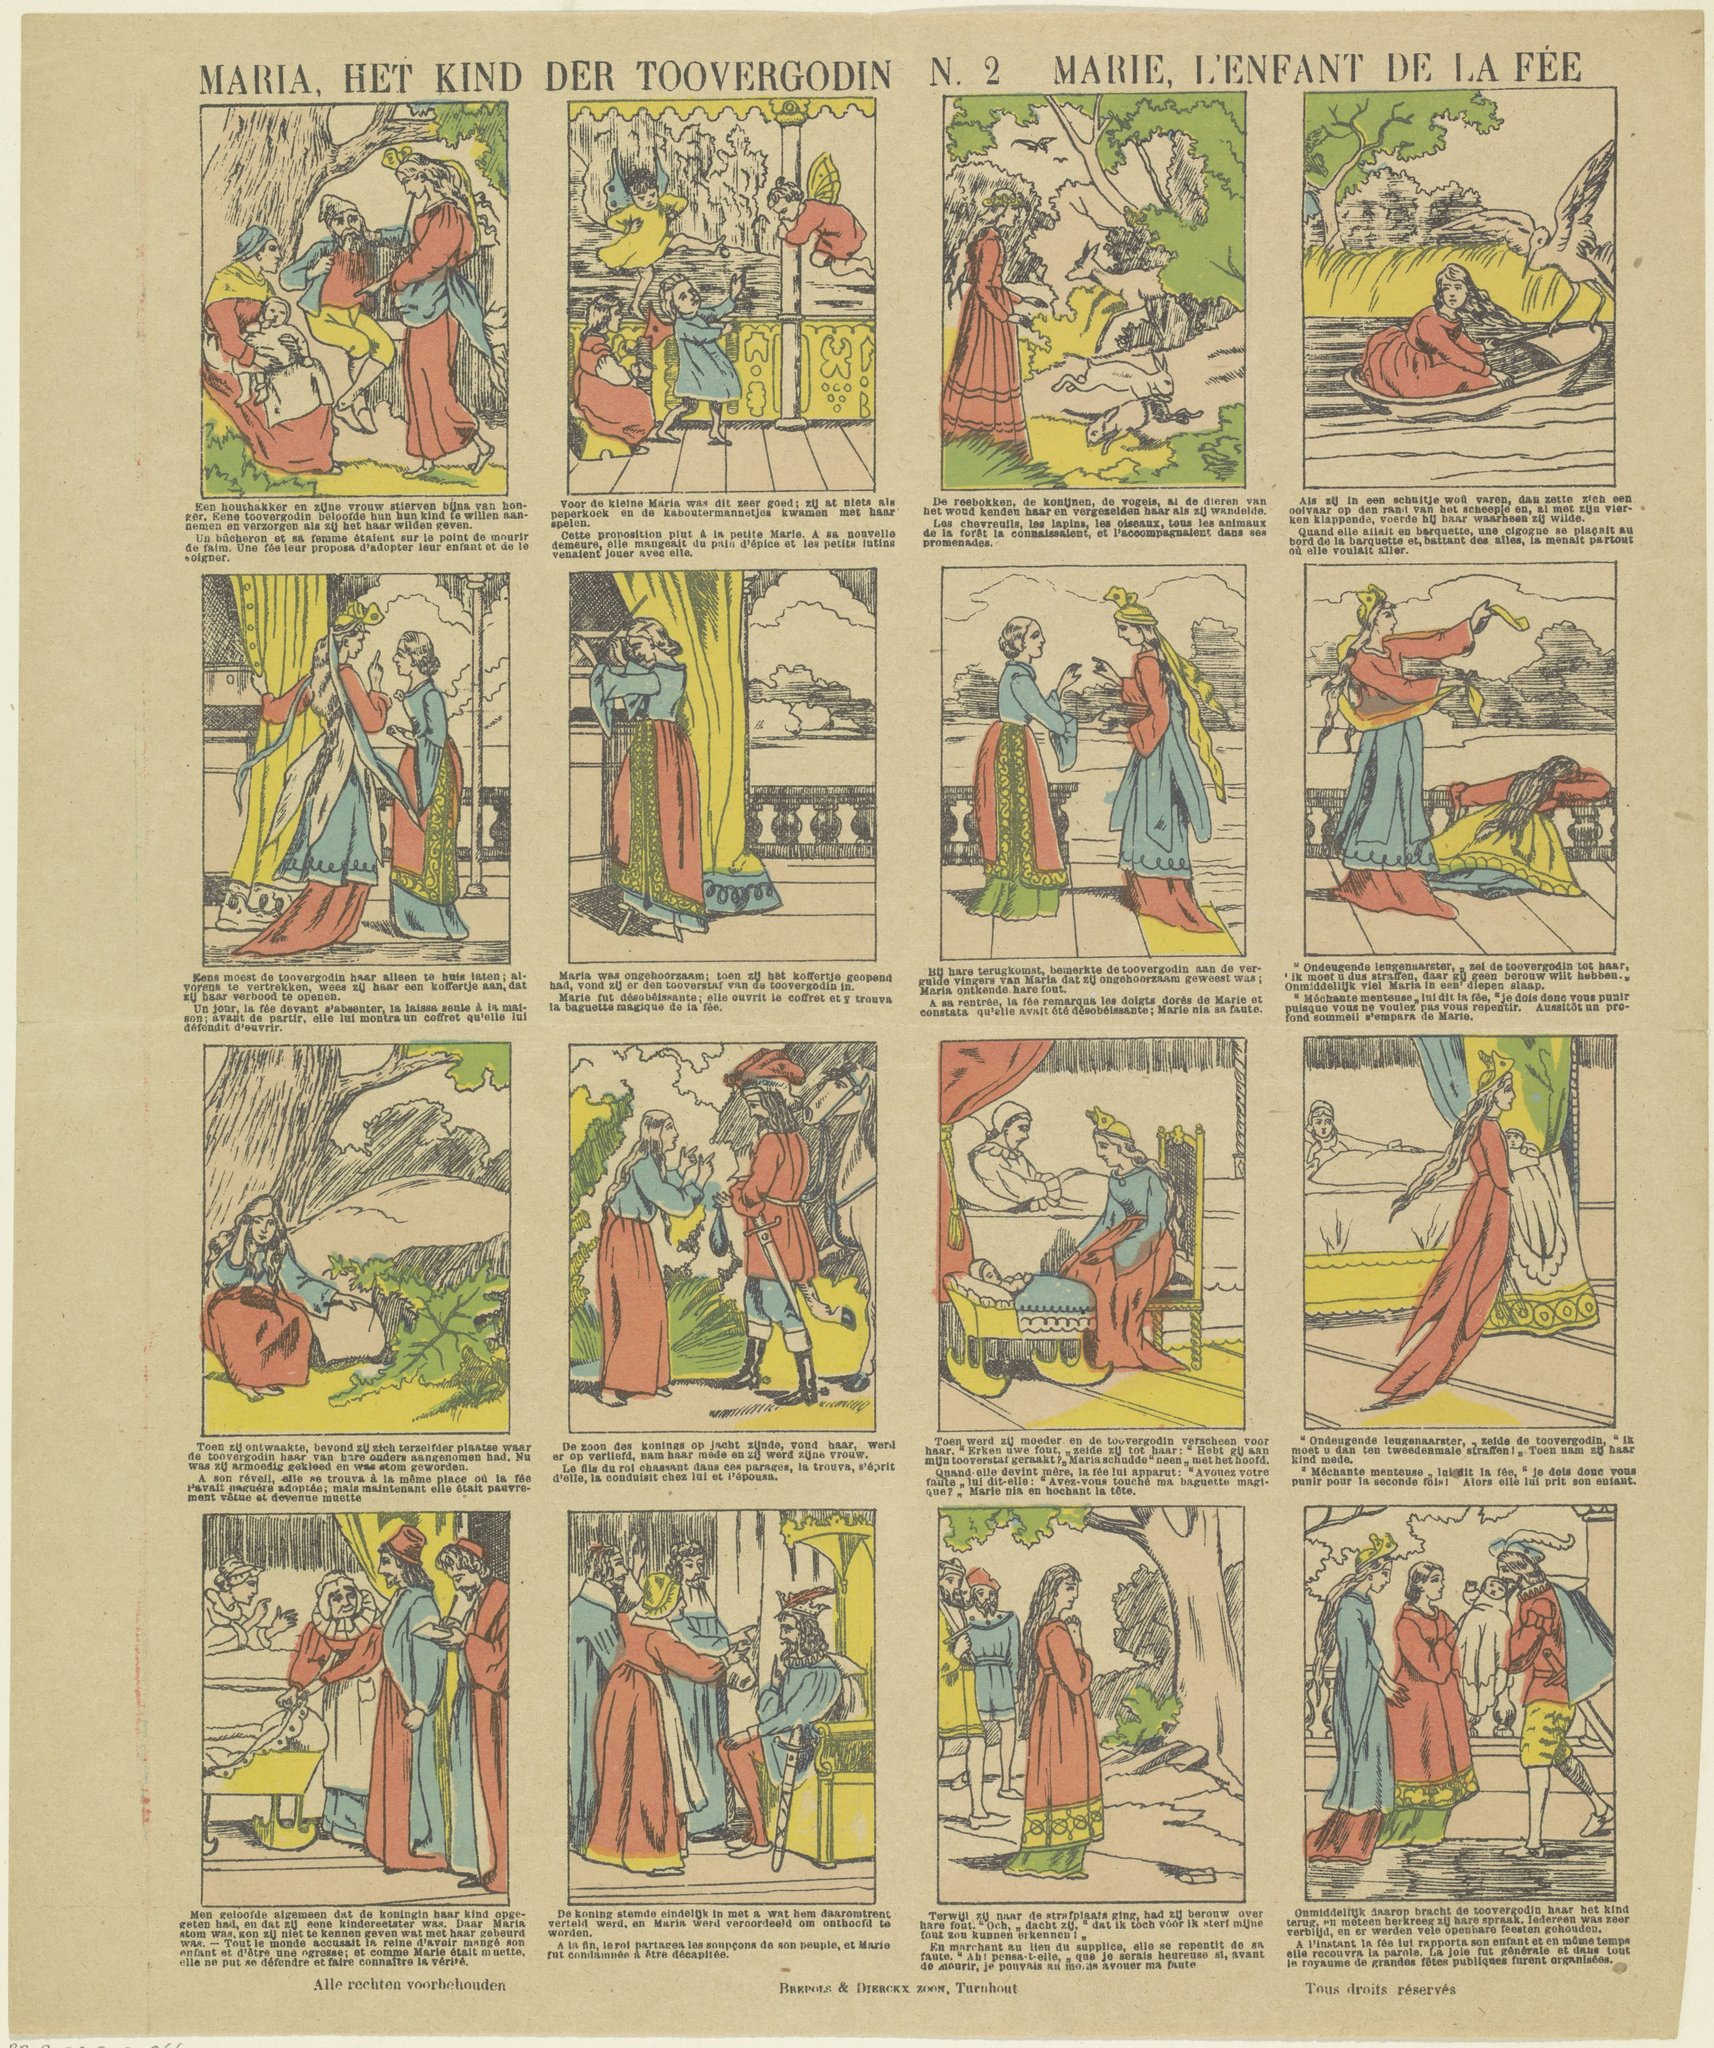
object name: print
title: Maria, het kind der toovergodin / Marie, l'enfant de la fée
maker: Anonymous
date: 1833-1911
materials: paper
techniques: lithograph, letterpress printing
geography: turnhout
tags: tales and fairy tales, representations ~ goddesses, demi-goddesses, heroines, etc. (non-christian religions)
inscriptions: collector's mark: Lugt 2760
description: Blad met 16 voorstellingen uit het sprookje van Maria, het kind van een tovergodin. Onder elke afbeelding een onderschrift in het Nederlands en in het Frans. Genummerd midden boven: N. 2.